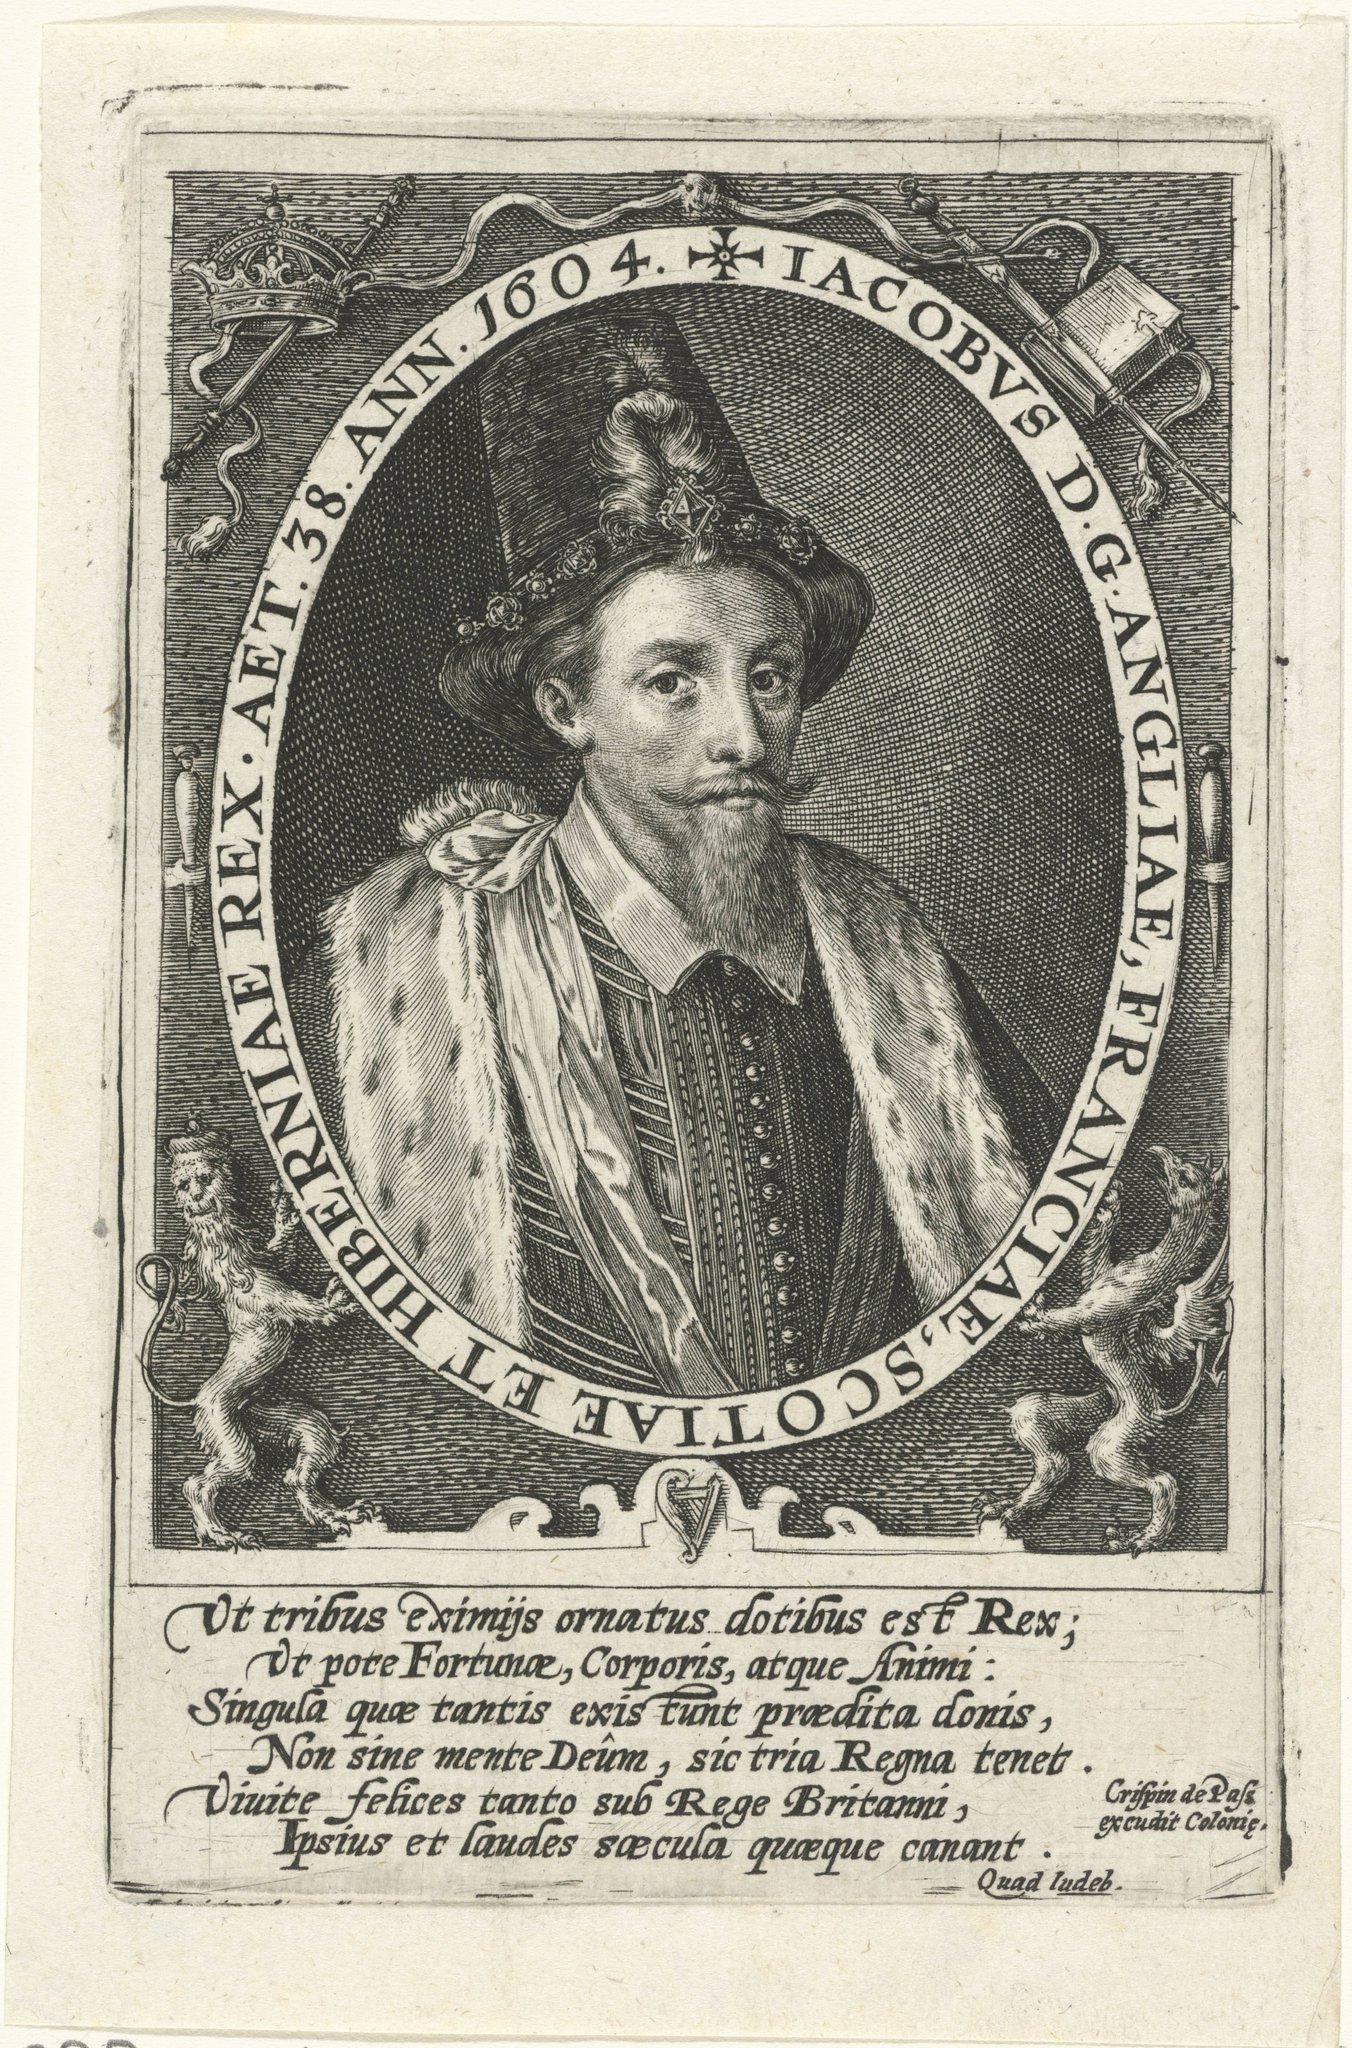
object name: print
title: Regiae Anglicae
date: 1604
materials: paper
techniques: engraving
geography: cologne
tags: jacobus i (koning van engeland), insignia and symbols of sovereignty (crown, diadem, sceptre, orb, seal, standard, cloak, pectoral)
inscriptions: collector's mark: Lugt 2228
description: Portret van James I, koning van Engeland, op 38-jarige leeftijd. In het randschrift van de omlijsting de naam, functie en leeftijd van de geportretteerde in het Latijn. In de marge een zesregelig lofdicht in het Latijn.